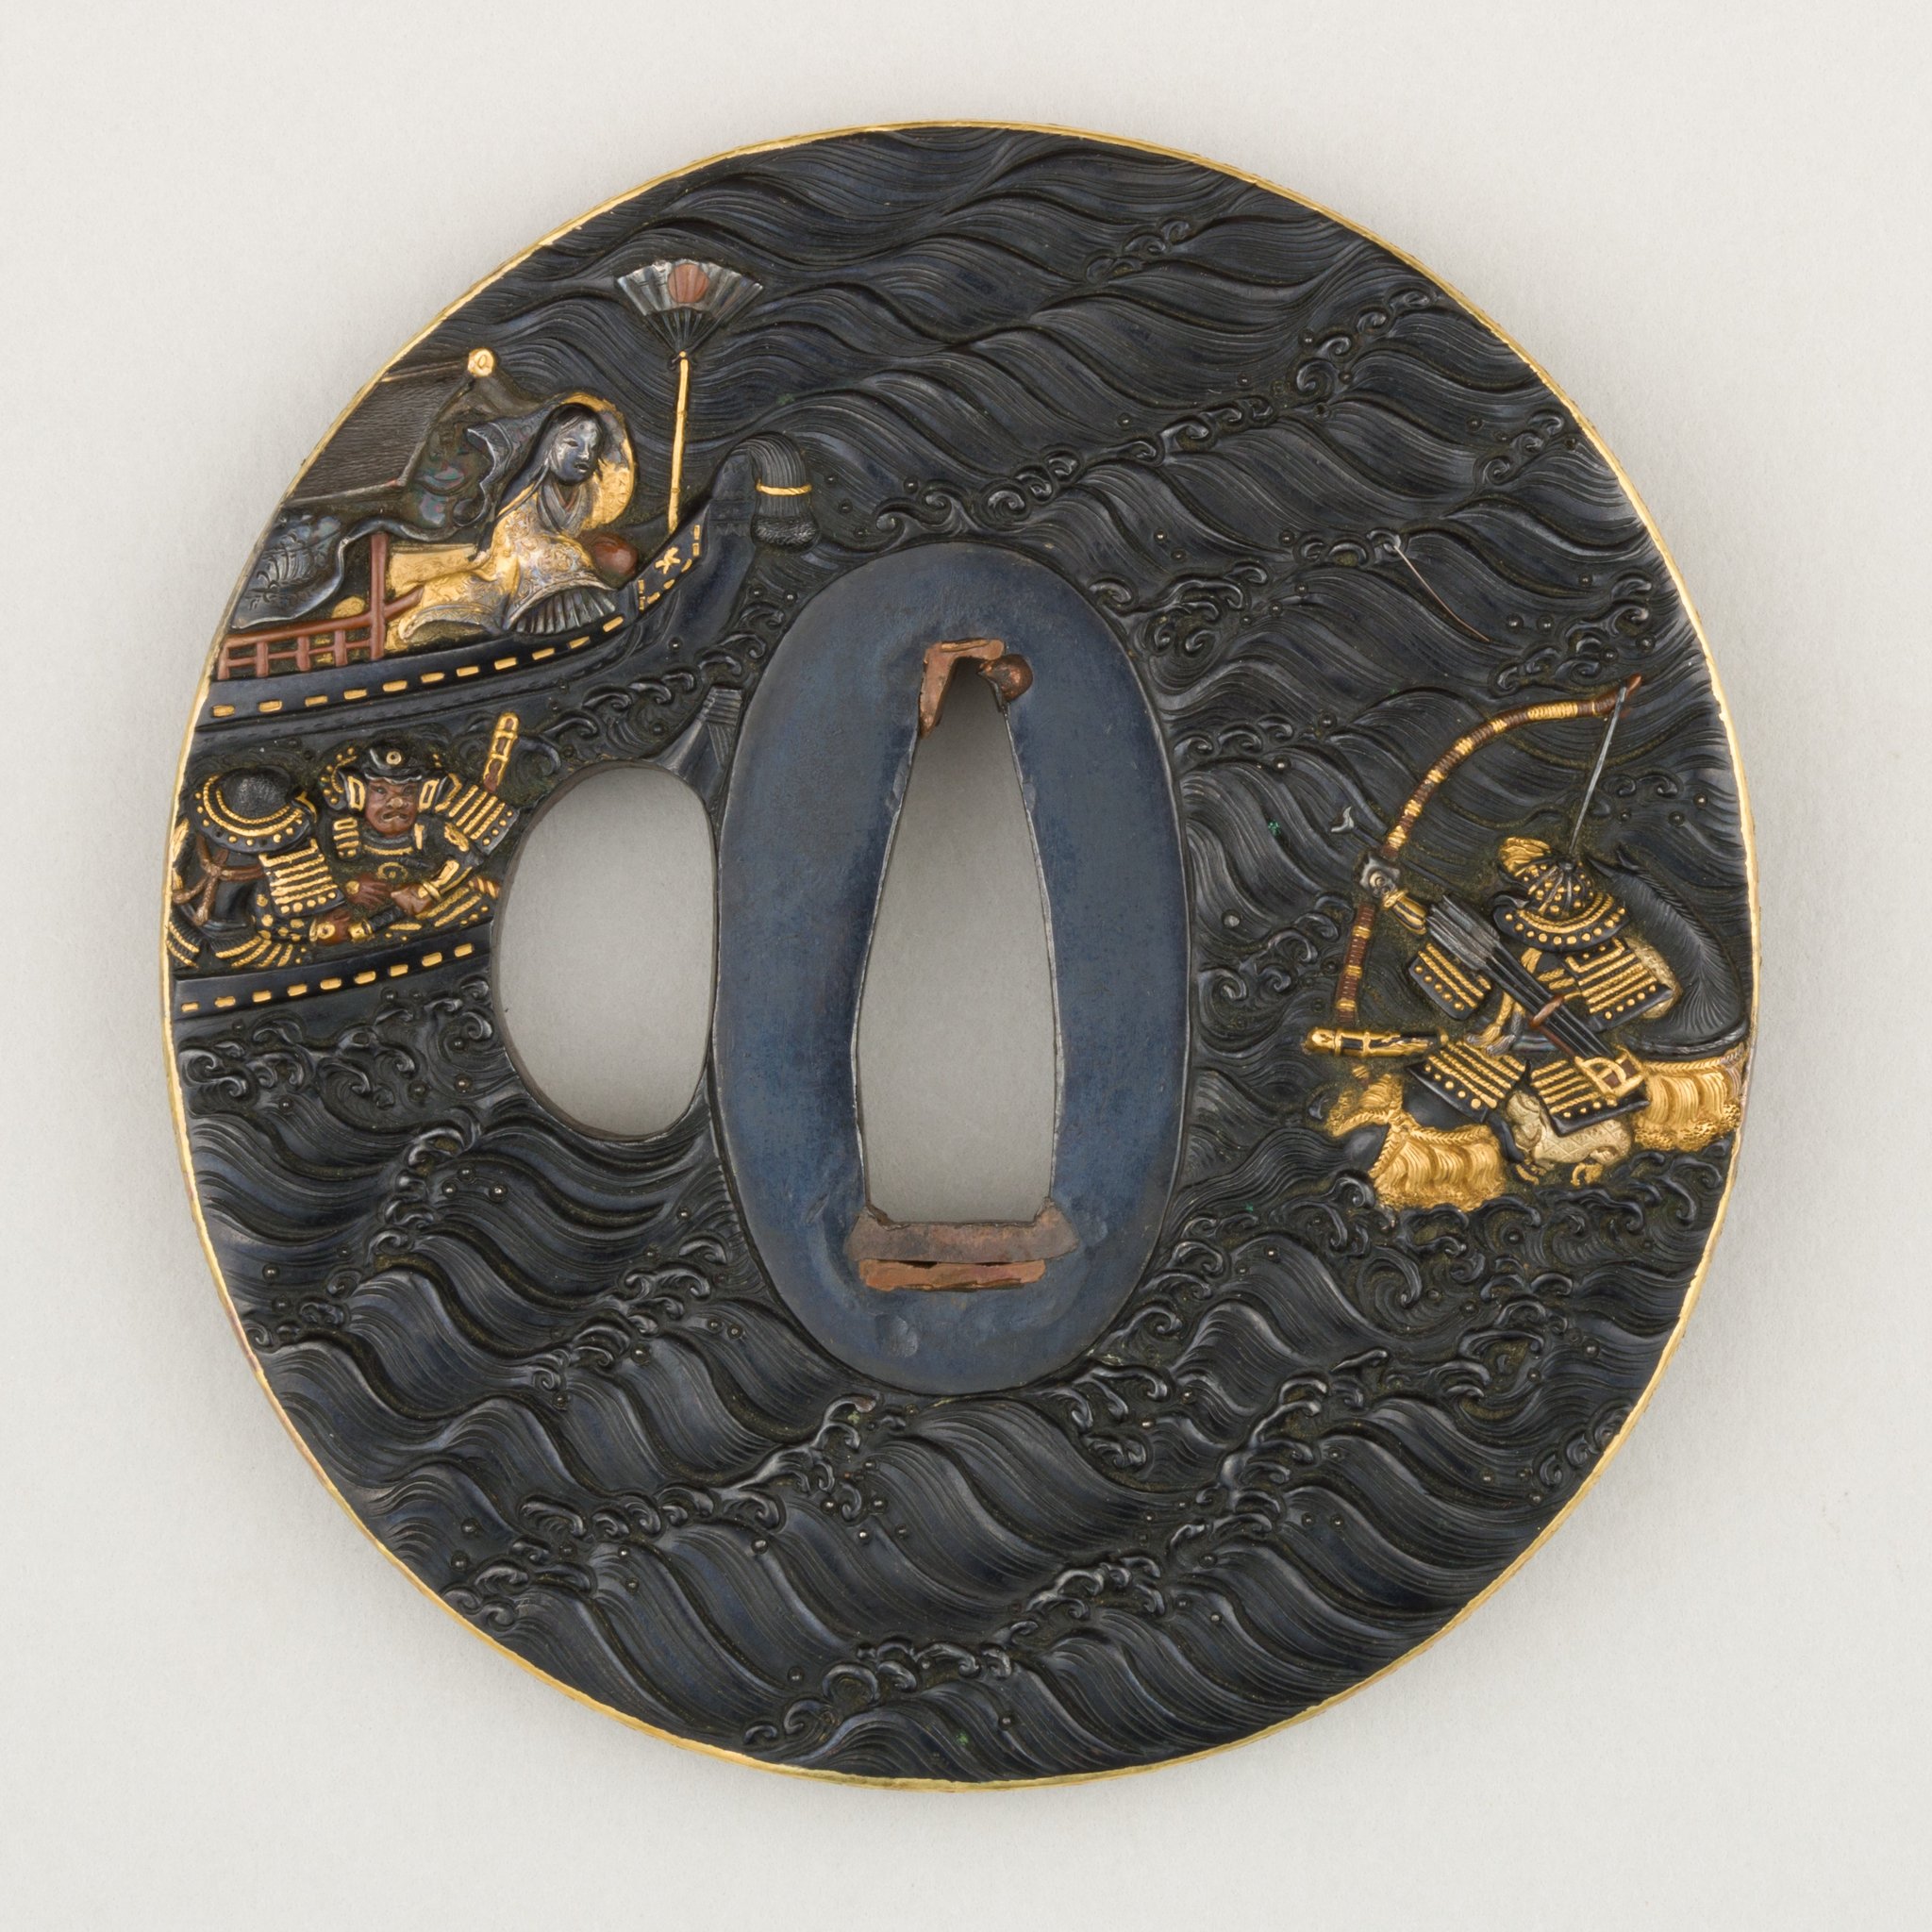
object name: sword guard tsuba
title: Sword Guard (Tsuba)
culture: japanese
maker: omori teruhide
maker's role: fittings maker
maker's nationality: japanese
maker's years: 1730-1798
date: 1701-1800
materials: gold alloy, silver alloy, gold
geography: japan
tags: human figures,bow and arrow,boats